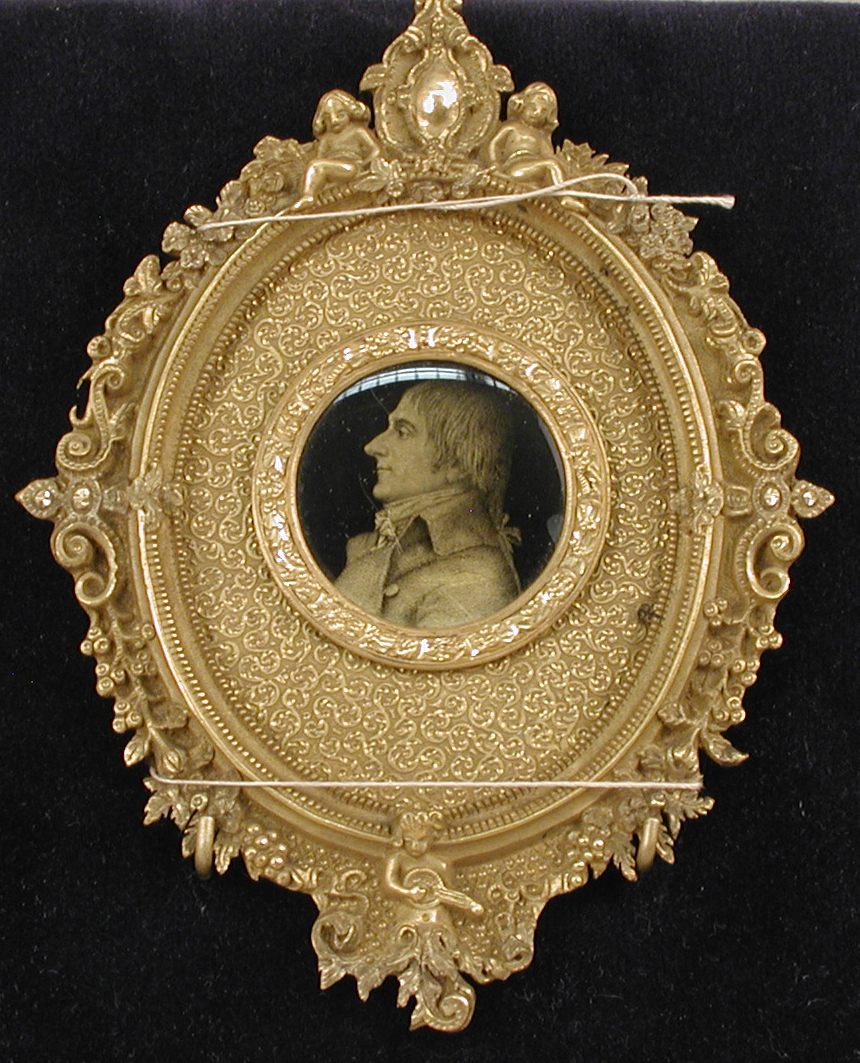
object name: medallion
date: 1767-1800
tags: men,profiles